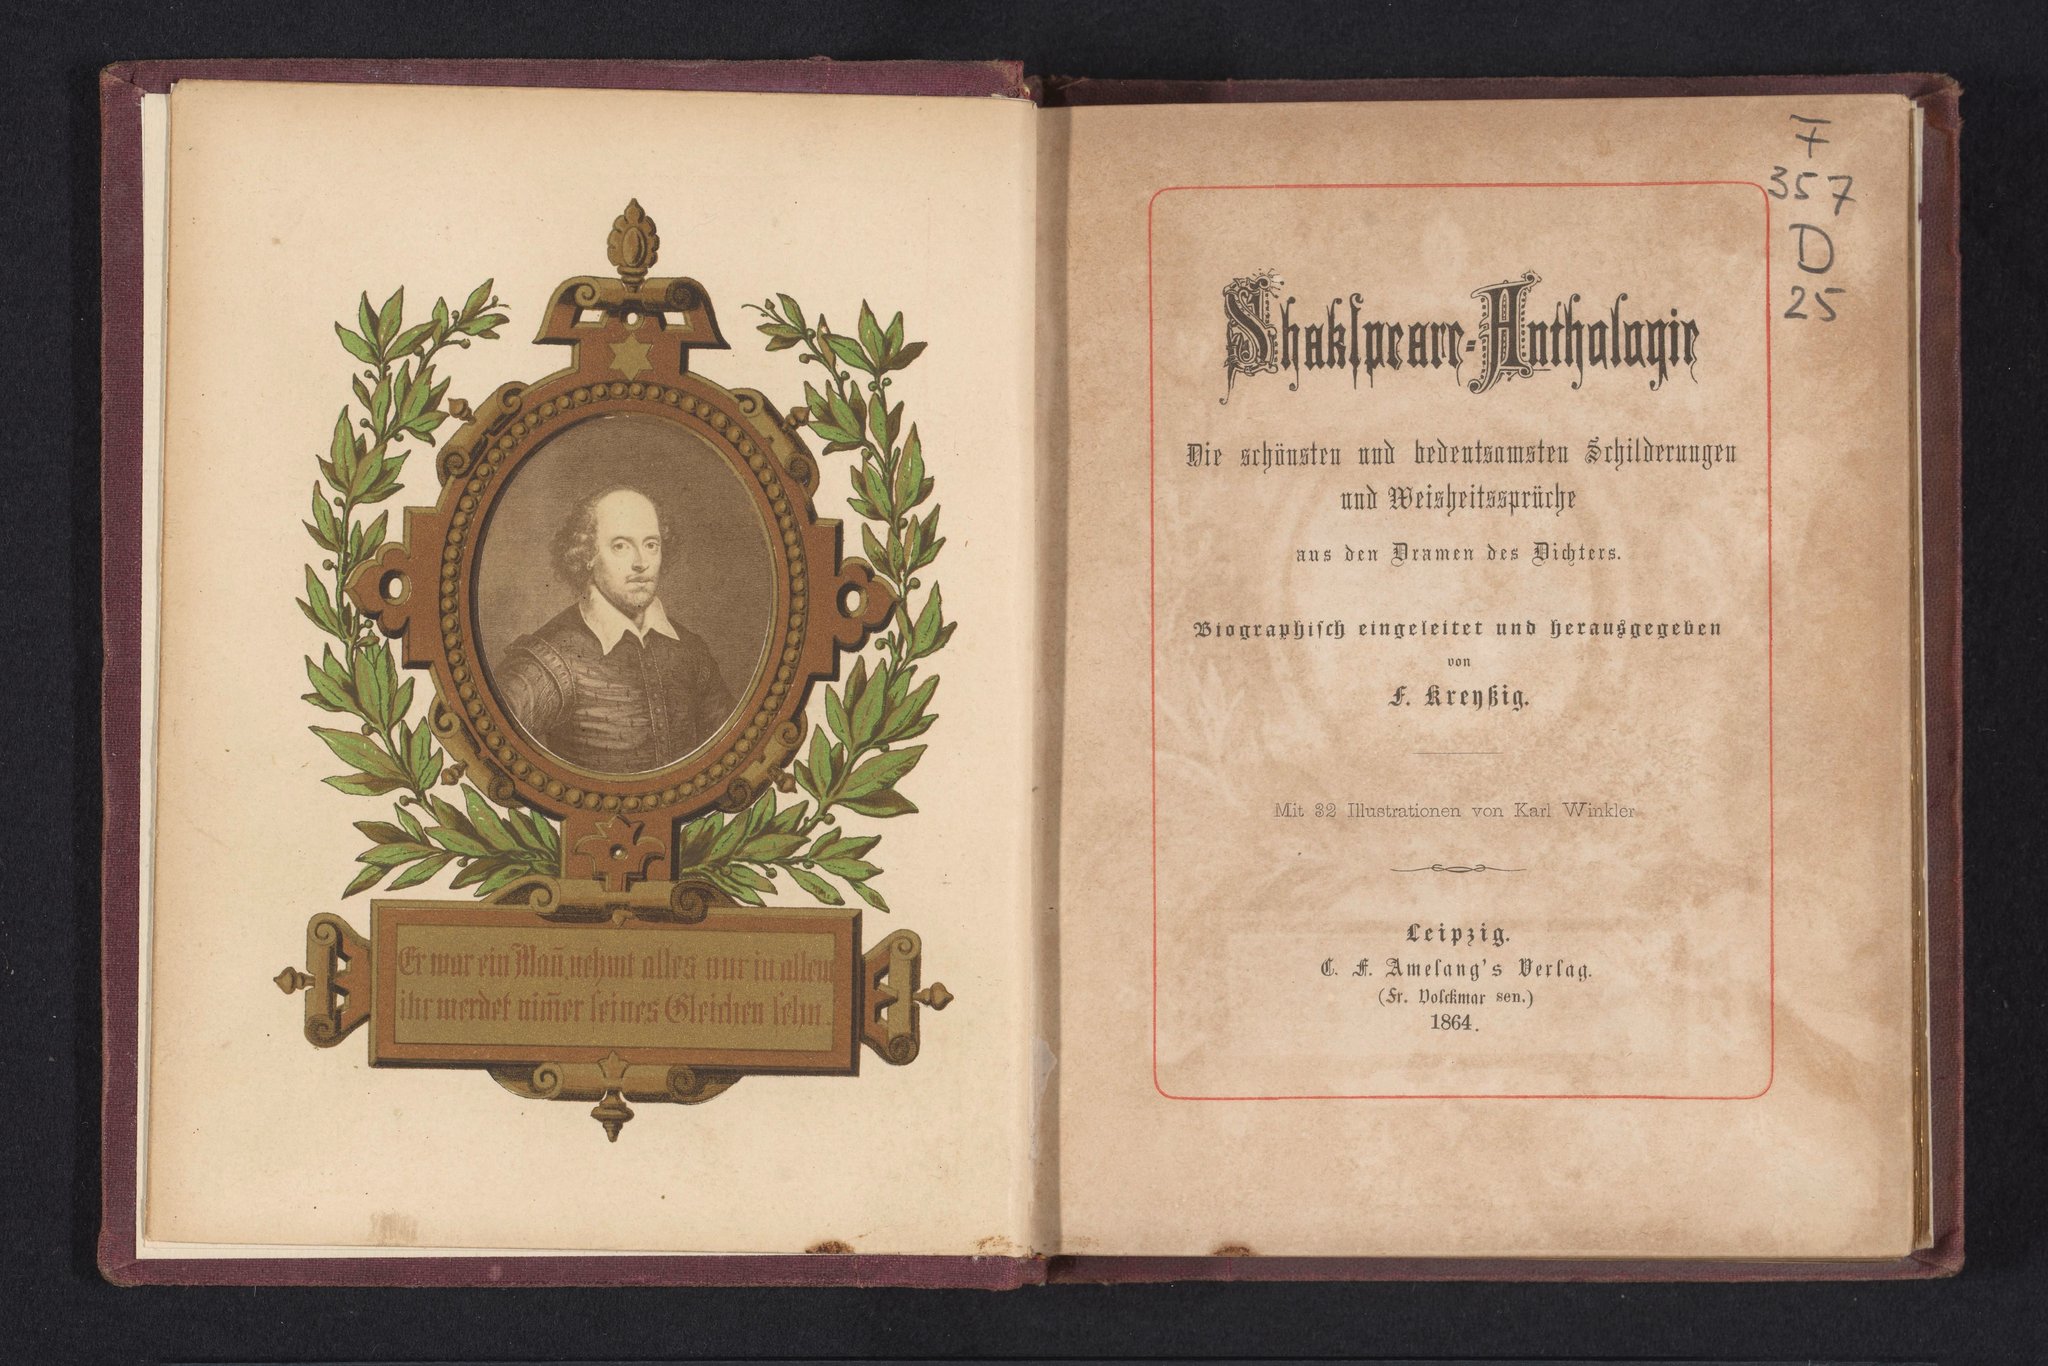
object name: book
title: Shakspeare-Anthologie : die schönsten und bedeutsamsten Schilderungen und Weisheitssprüche aus den Dramen des Dichters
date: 1864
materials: cardboard, linen, paper, photographic support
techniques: albumen print, printing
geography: leipzig